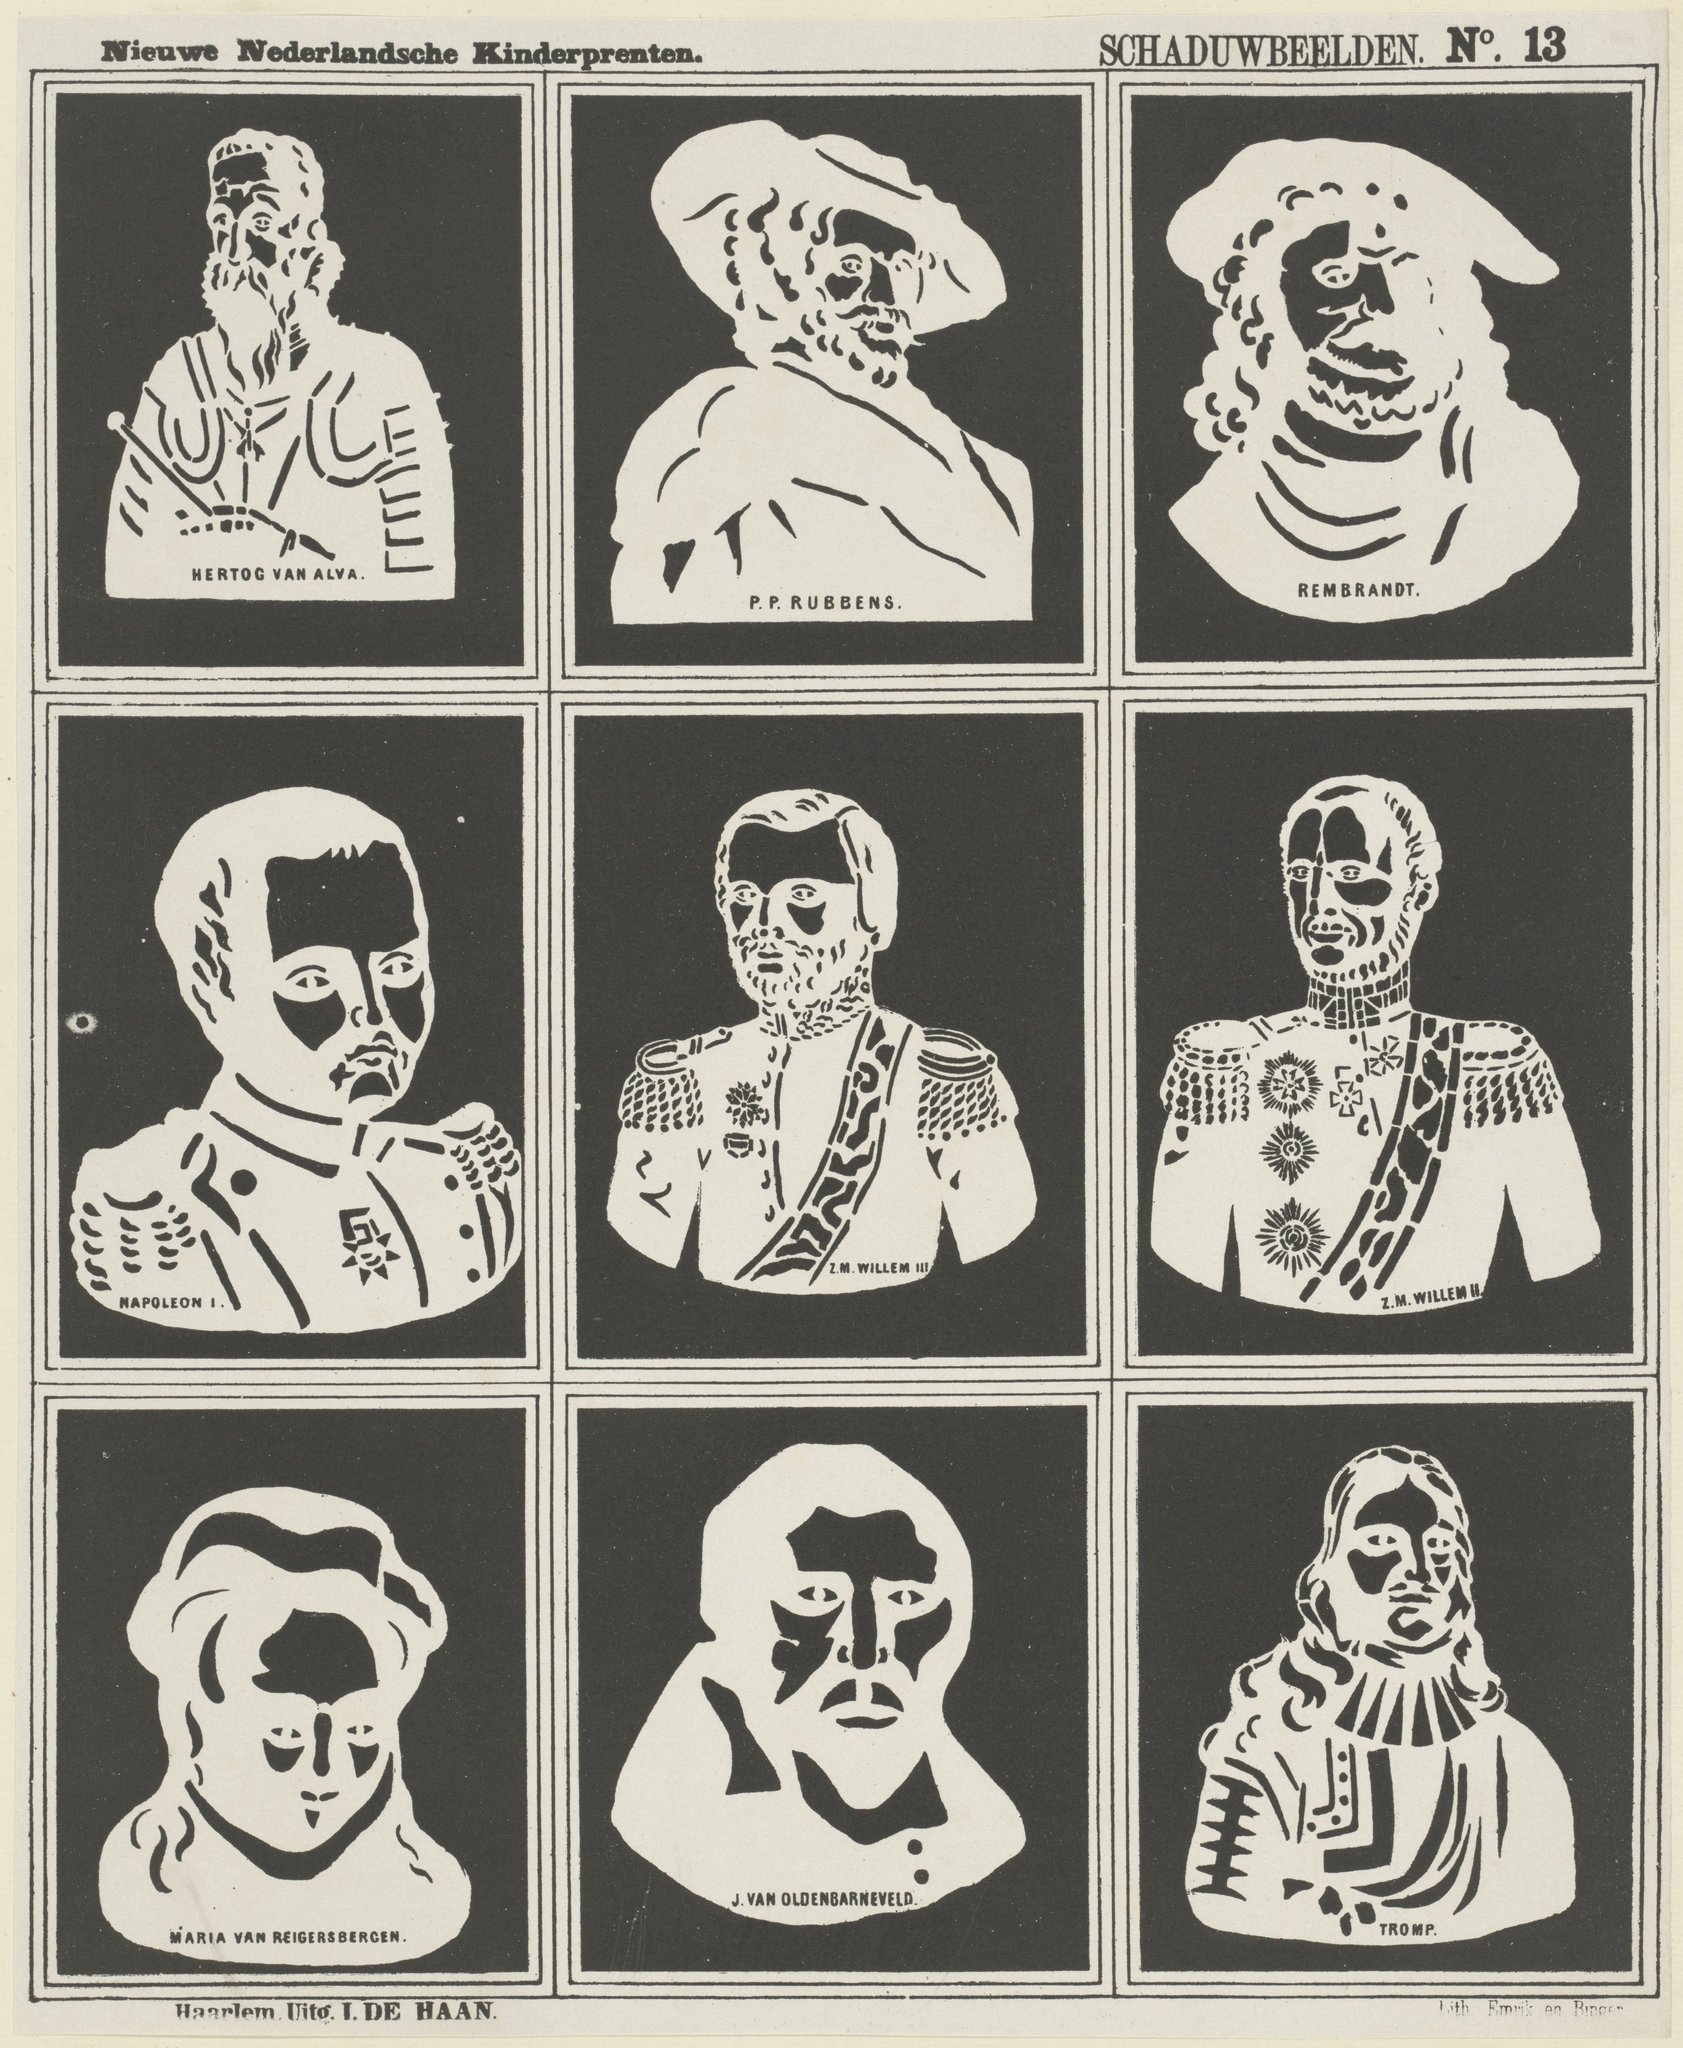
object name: print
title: Schaduwbeelden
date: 1875-1903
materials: paper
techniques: letterpress printing, lithograph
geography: haarlem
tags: johan van oldenbarnevelt, rotterdam, amsterdam, cornelis tromp, leiden, painter, print maker, draughtsman, rembrandt van rijn, brussels, willem iii (koning der nederlanden), william ii of the netherlands, fernando álvarez de toledo (3rd duke of alba), antwerp, peter paul rubens, napoleon i (emperor of the french)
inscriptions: collector's mark: Lugt 2760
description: Blad met 9 schaduwbeelden (portretten) van historische figuren, onder wie Rembrandt Harmensz. van Rijn, Napoleon I Bonaparte, Maria van Reigersberch en Johan van Oldenbarnevelt. Genummerd rechtsboven: No. 13.